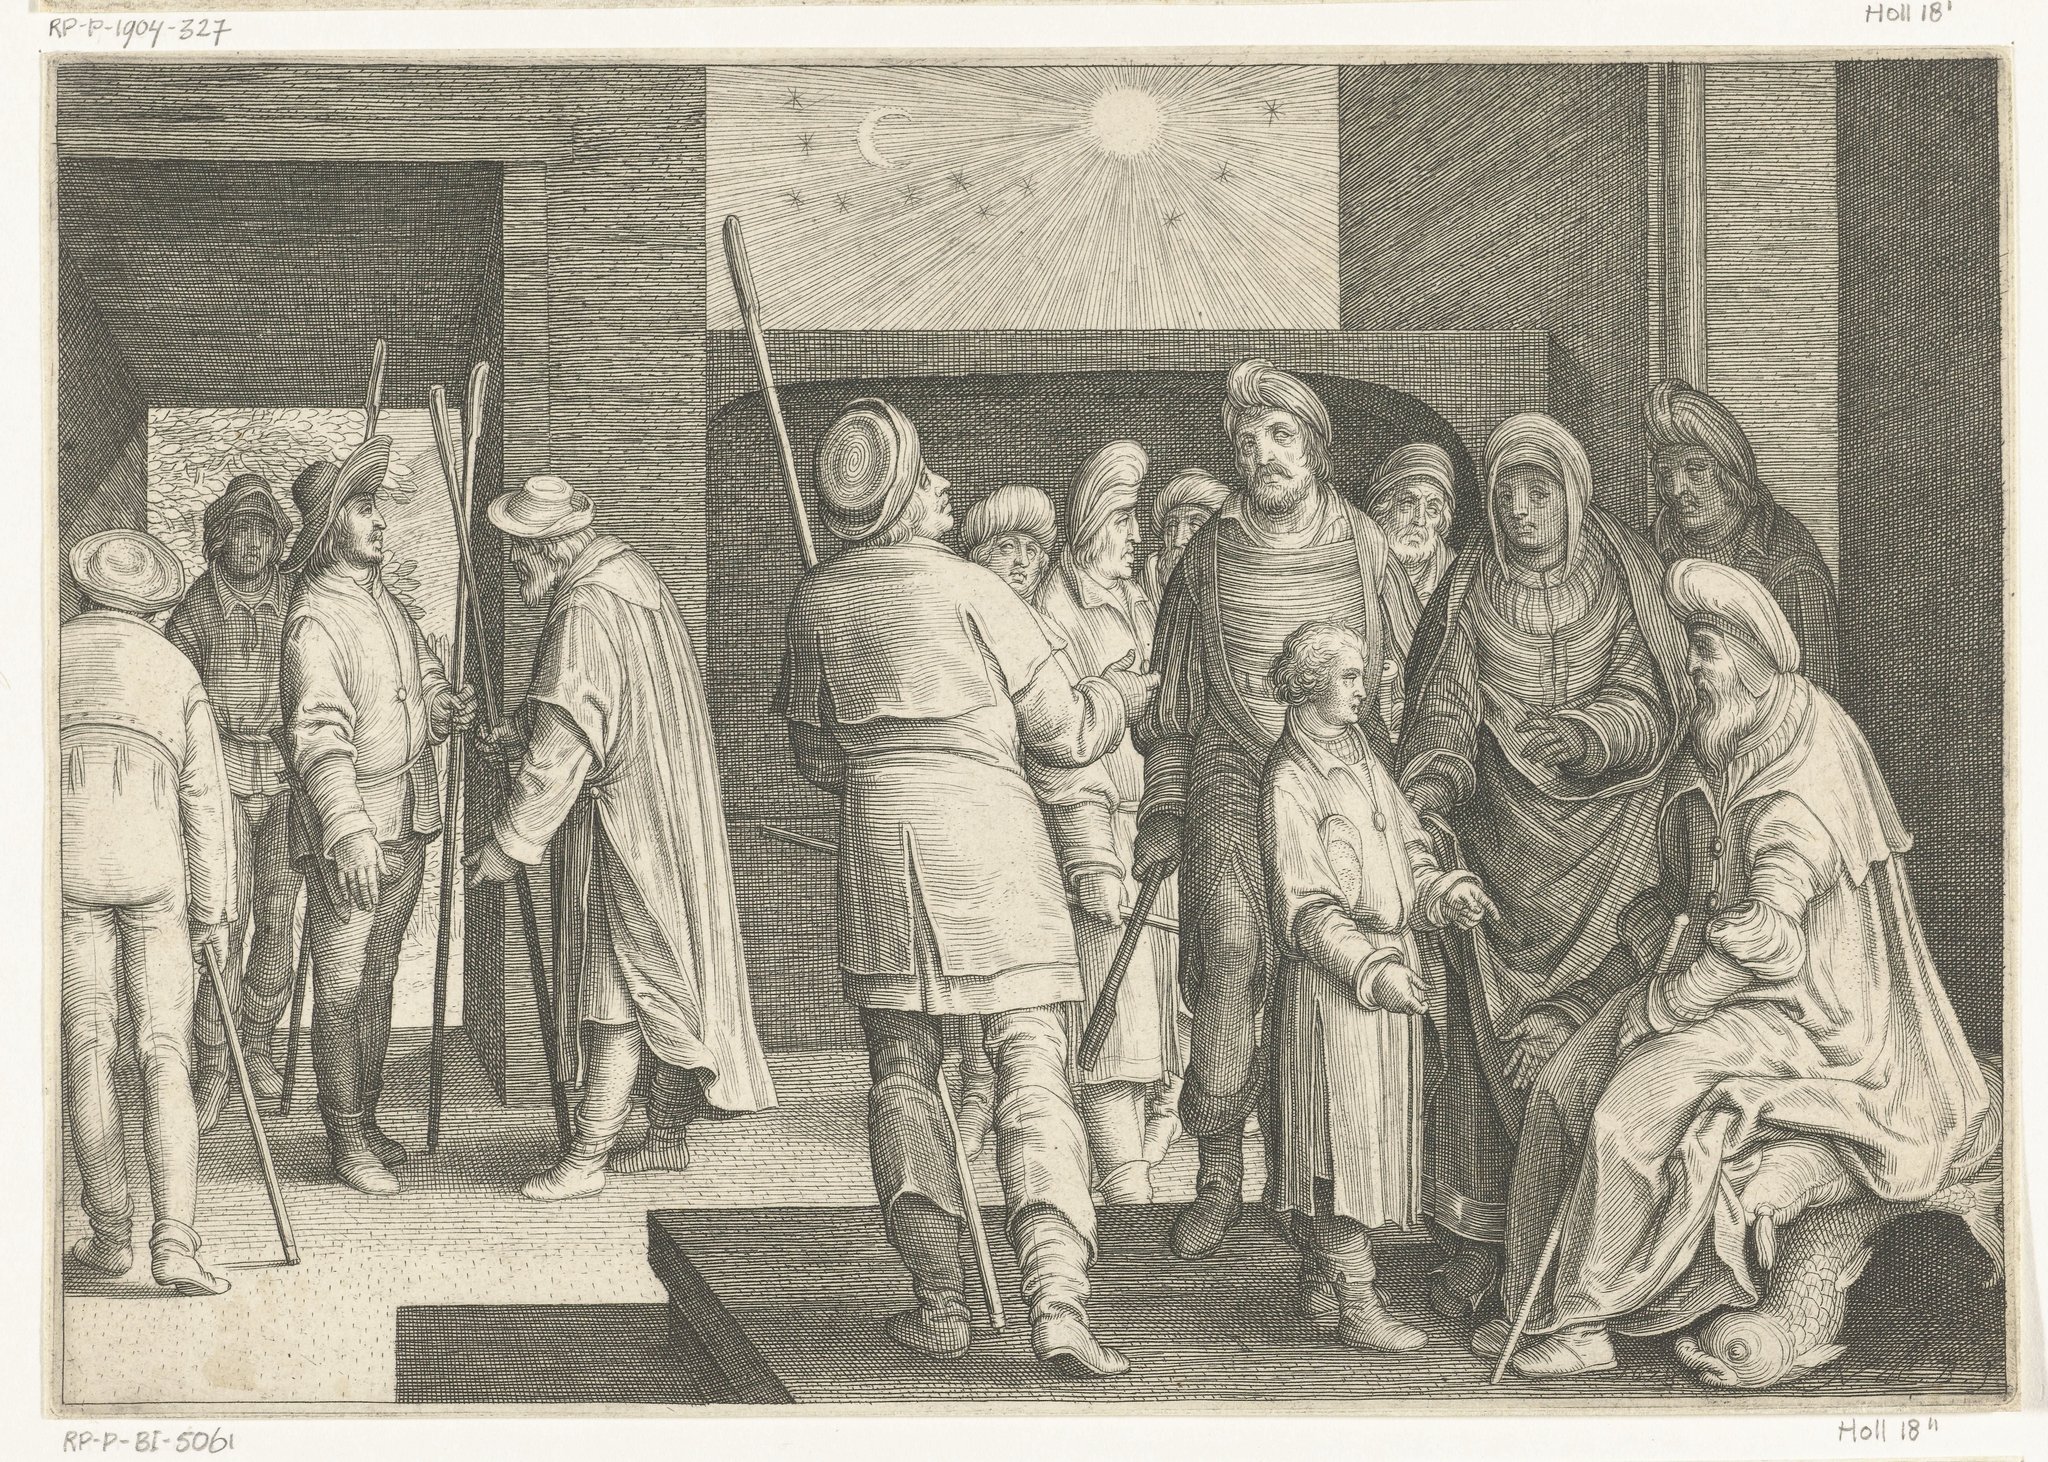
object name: print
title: Jozef legt aan Jakob zijn tweede droom uit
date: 1628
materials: paper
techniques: engraving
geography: netherlands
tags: joseph relates his first dream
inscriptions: collector's mark: Lugt 2228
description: Prent uit serie van zes prenten met het verhaal van Jozef. De serie is geïnspireerd op een vergelijkbare reeks van Lucas van Leyden.